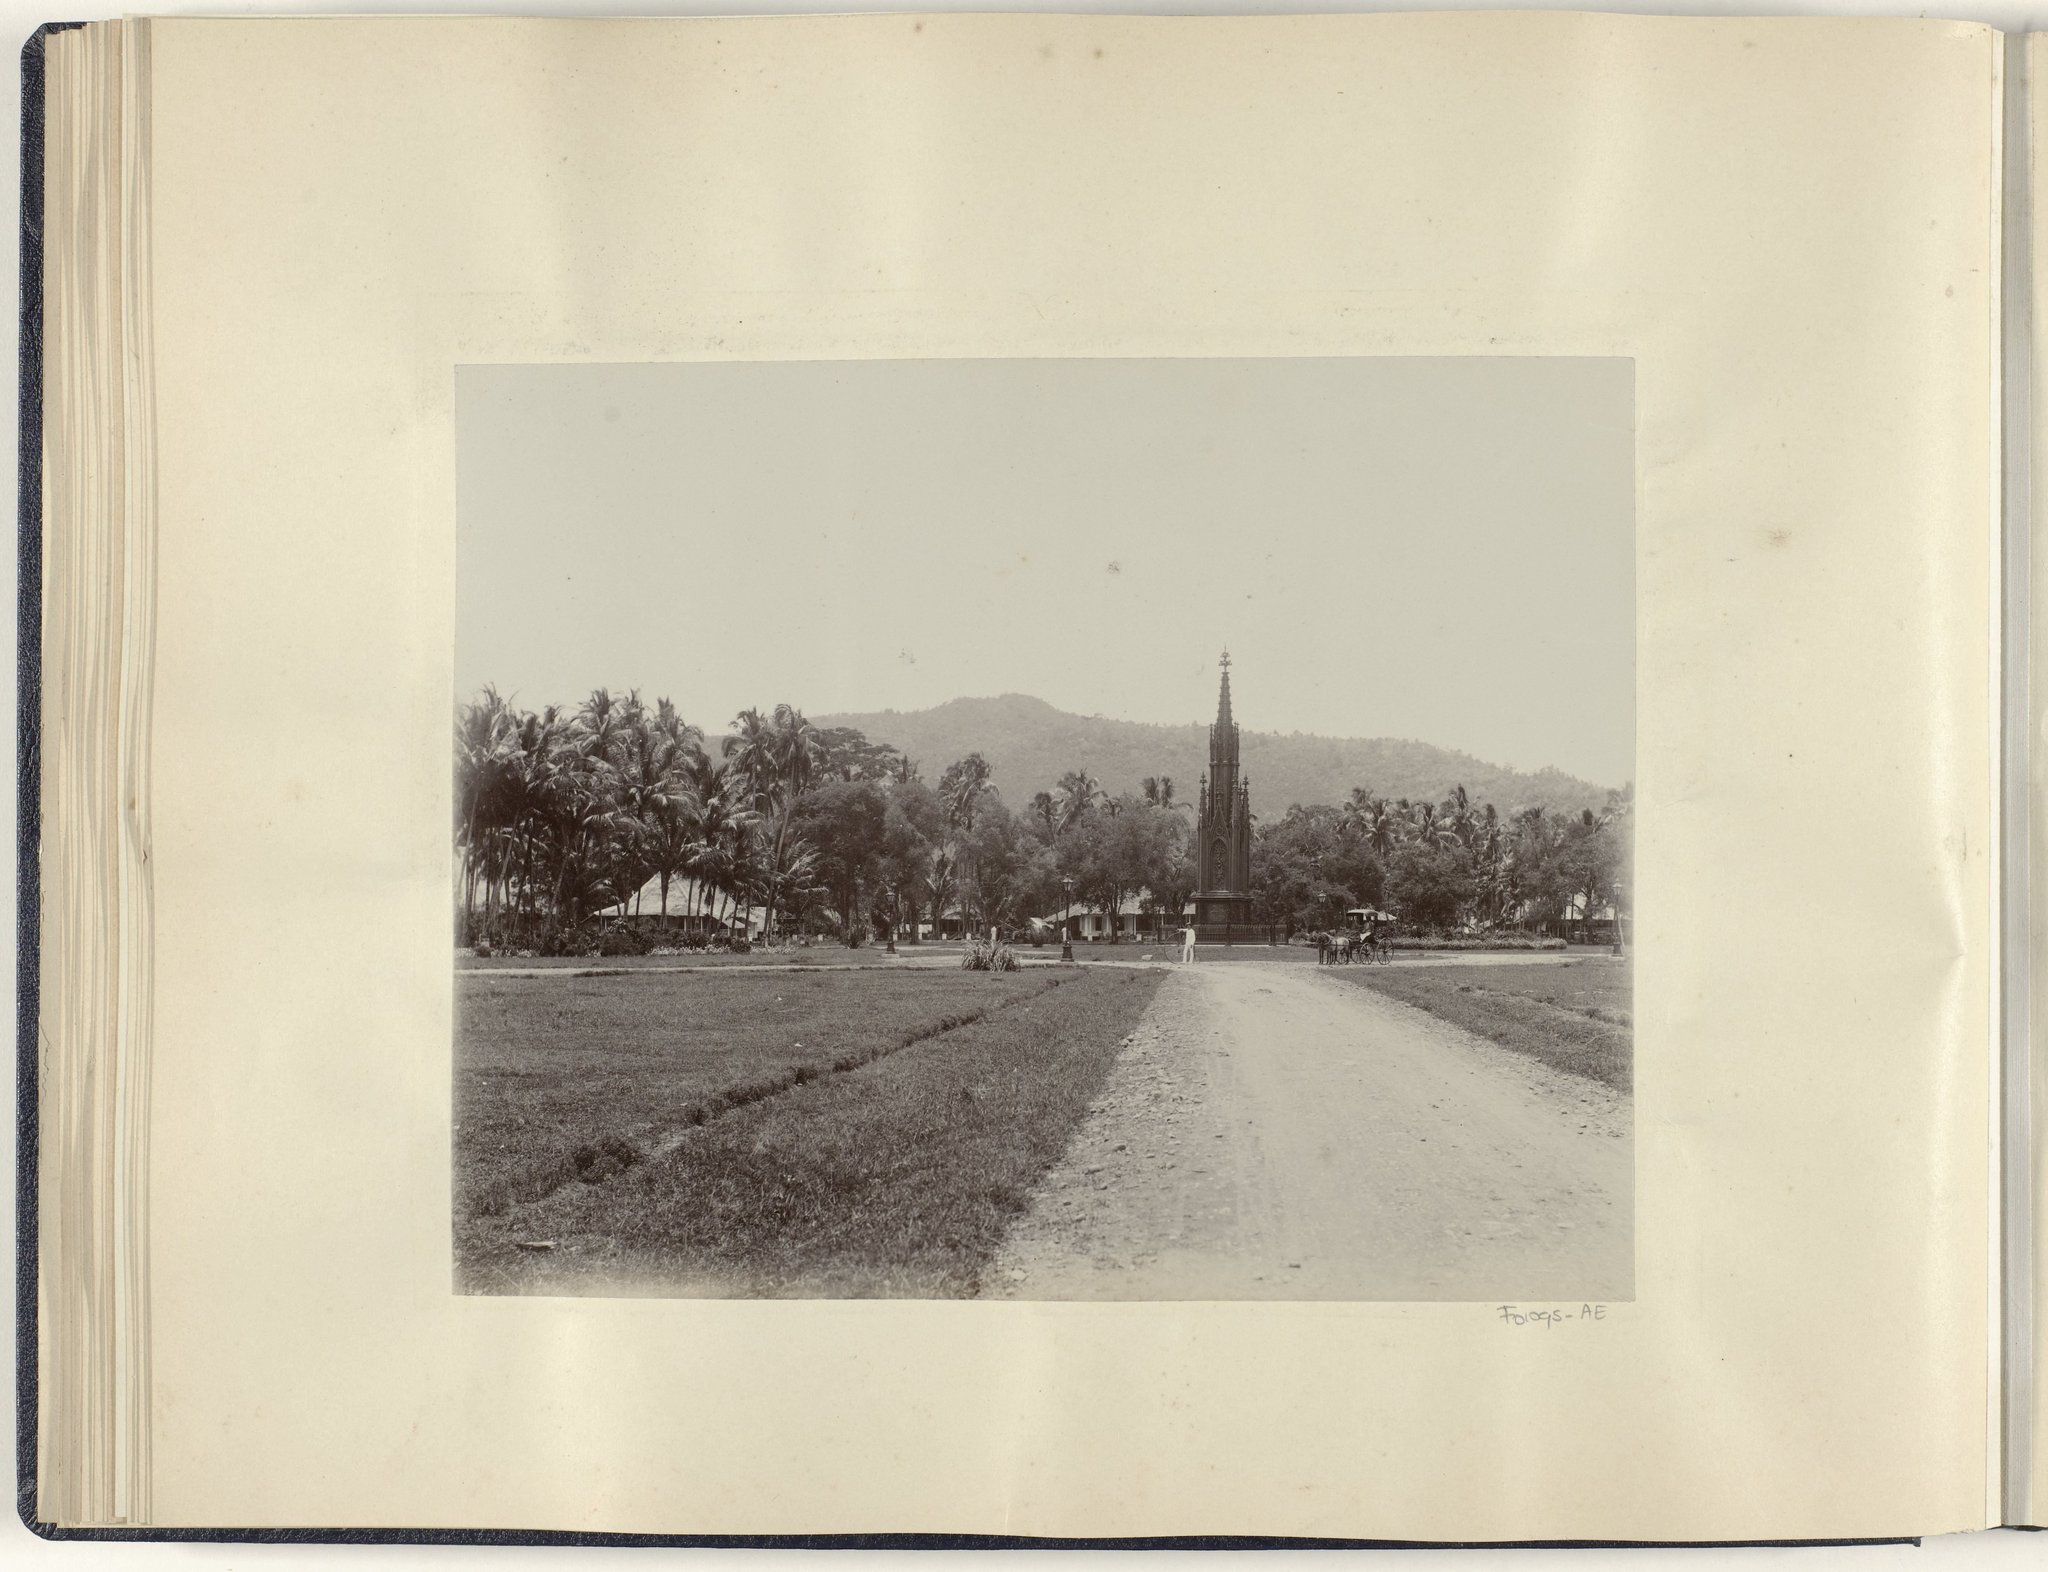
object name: photograph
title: Monument op een plein in Nederlands-Indië met daarvoor een rijtuig en een vélocipède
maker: christiaan benjamin nieuwenhuis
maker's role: publisher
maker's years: 1863-1922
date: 1895-1905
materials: paper, photographic support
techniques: albumen print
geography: dutch east indies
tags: four-wheeled, animal-drawn vehicle, e.g.: cab, carriage, coach, monument, statue, bicycle, dutch east indies, the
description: Onderdeel van Reisalbum met foto's van bezienswaardigheden in Italië, Zwitserland en Nederlands-Indië.